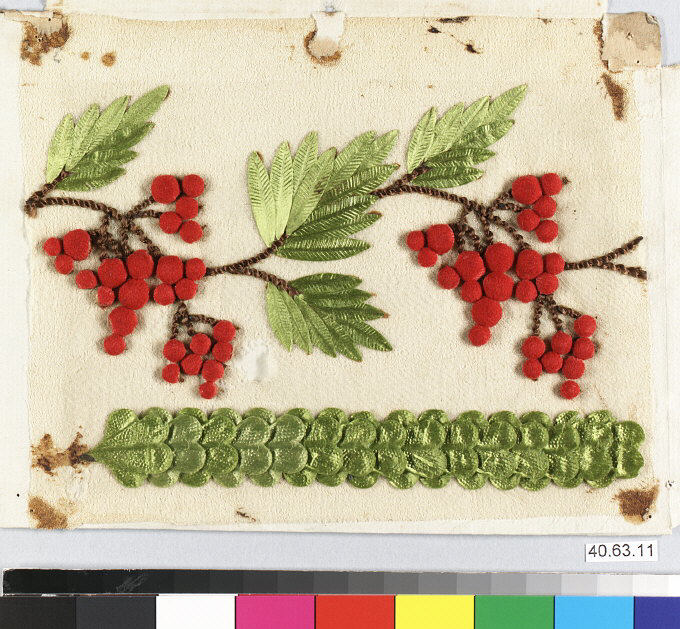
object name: border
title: Dress border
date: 1801-1833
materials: silk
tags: fruit